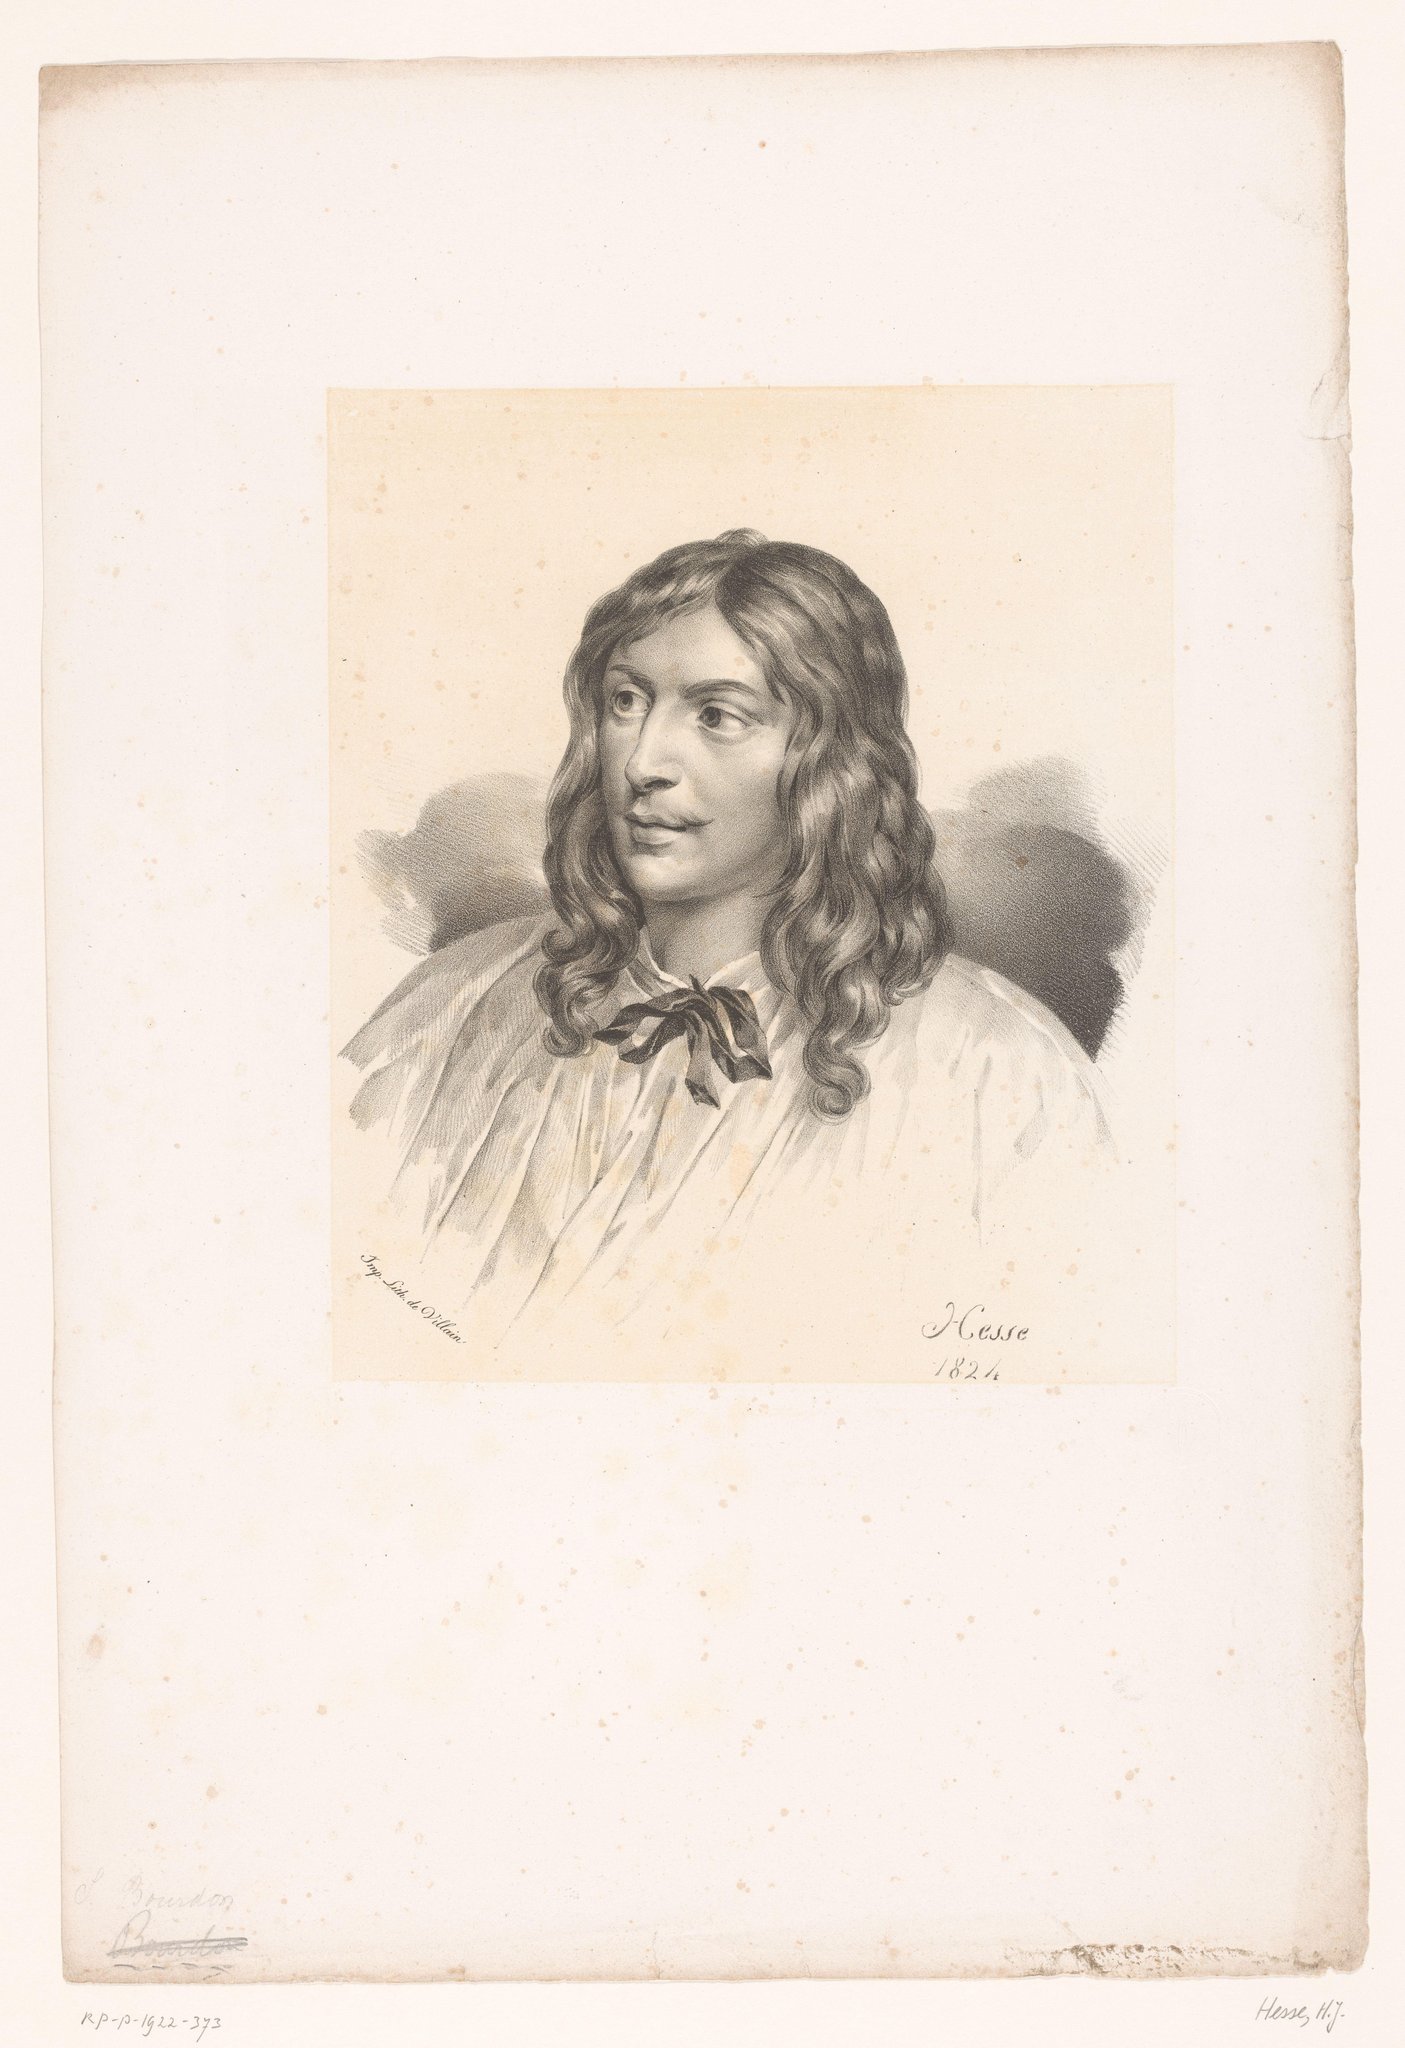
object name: print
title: Portret van Sébastien Bourdon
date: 1824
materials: paper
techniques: lithograph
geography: paris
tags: paris, painter, print maker, draughtsman, sébastien bourdon, historical persons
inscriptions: check stamp: ‘JC (?)’, collector's mark: Lugt 2233